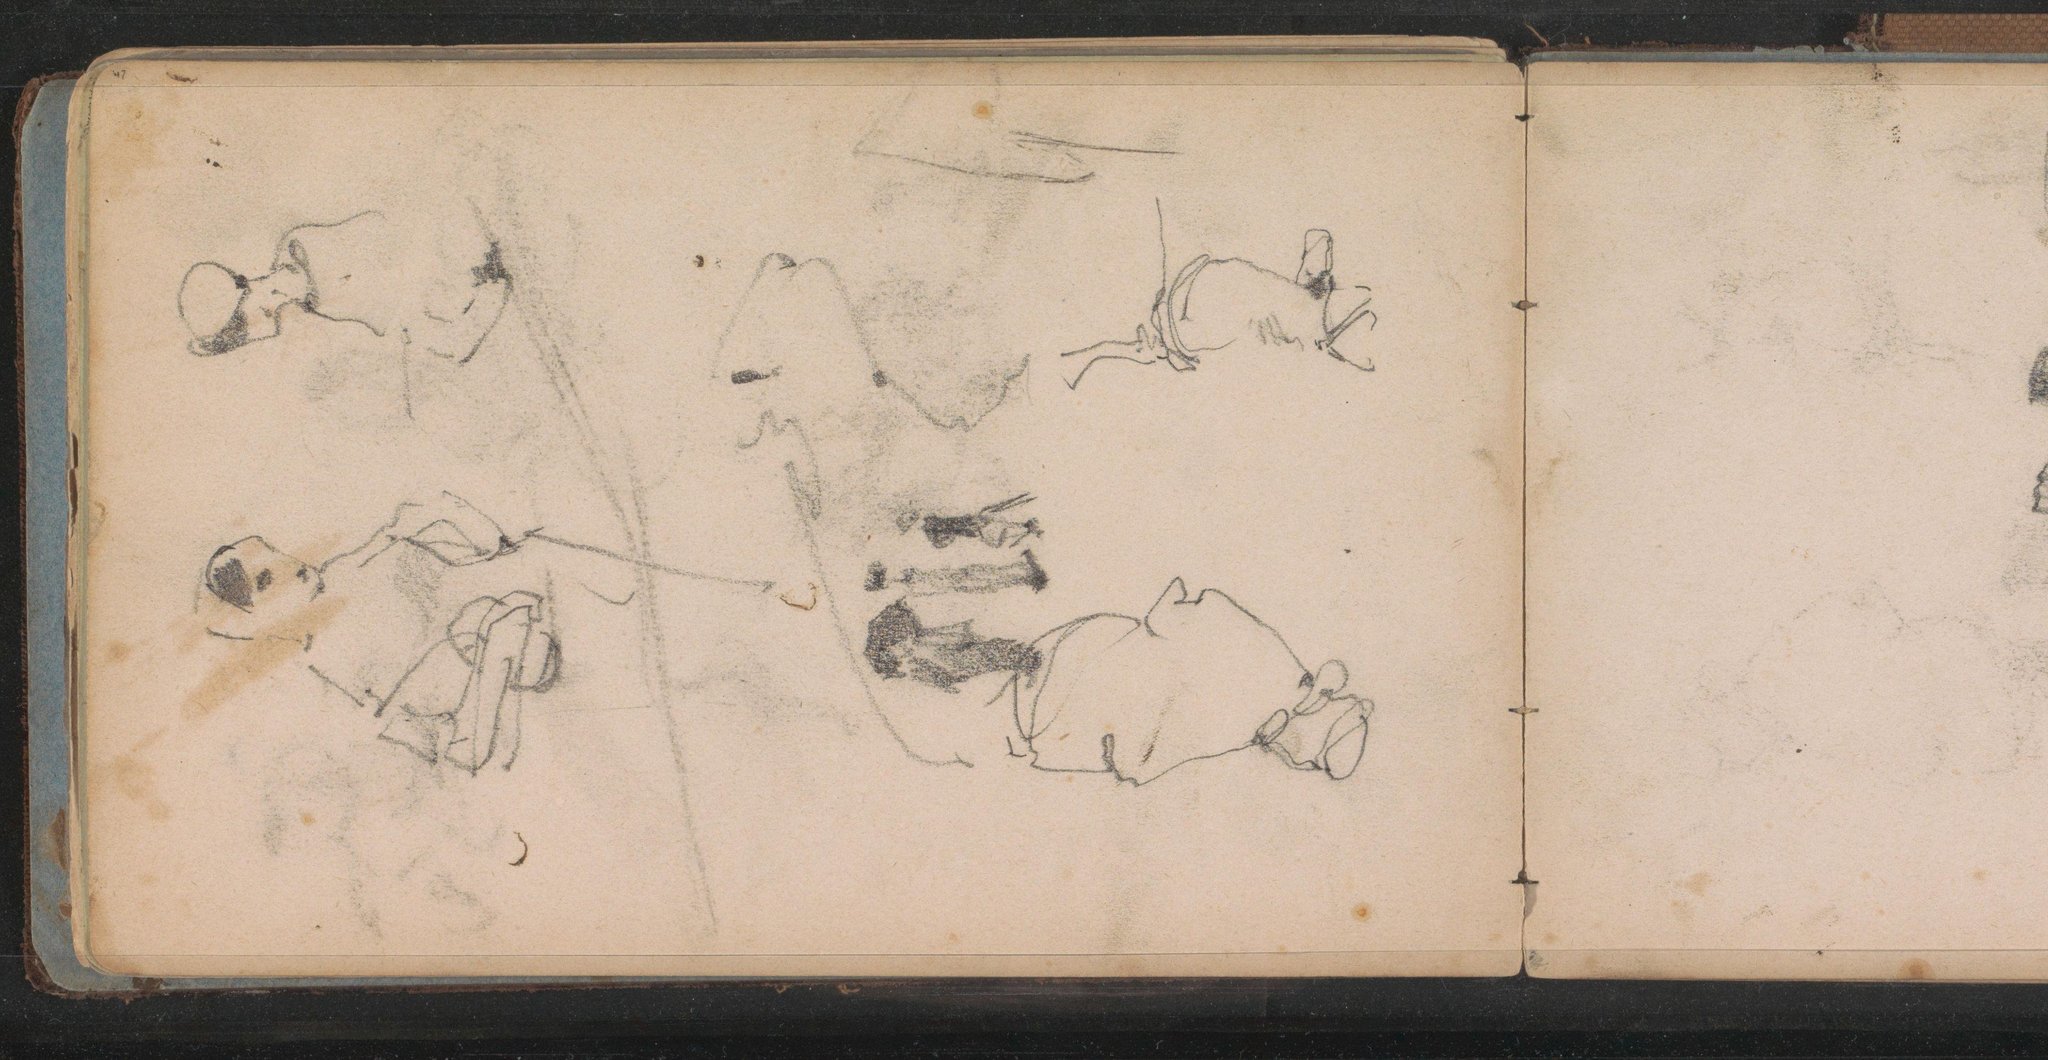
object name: sketchbook leaf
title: Figuurstudies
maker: george hendrik breitner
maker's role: draughtsman, painter, print maker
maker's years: 1857-1923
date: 1880-1882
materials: paper, pencil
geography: scheveningen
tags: adult woman, adult man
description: Mogelijk onder andere vissersvrouwen. Pagina 47 uit een schetsboek met 37 bladen.